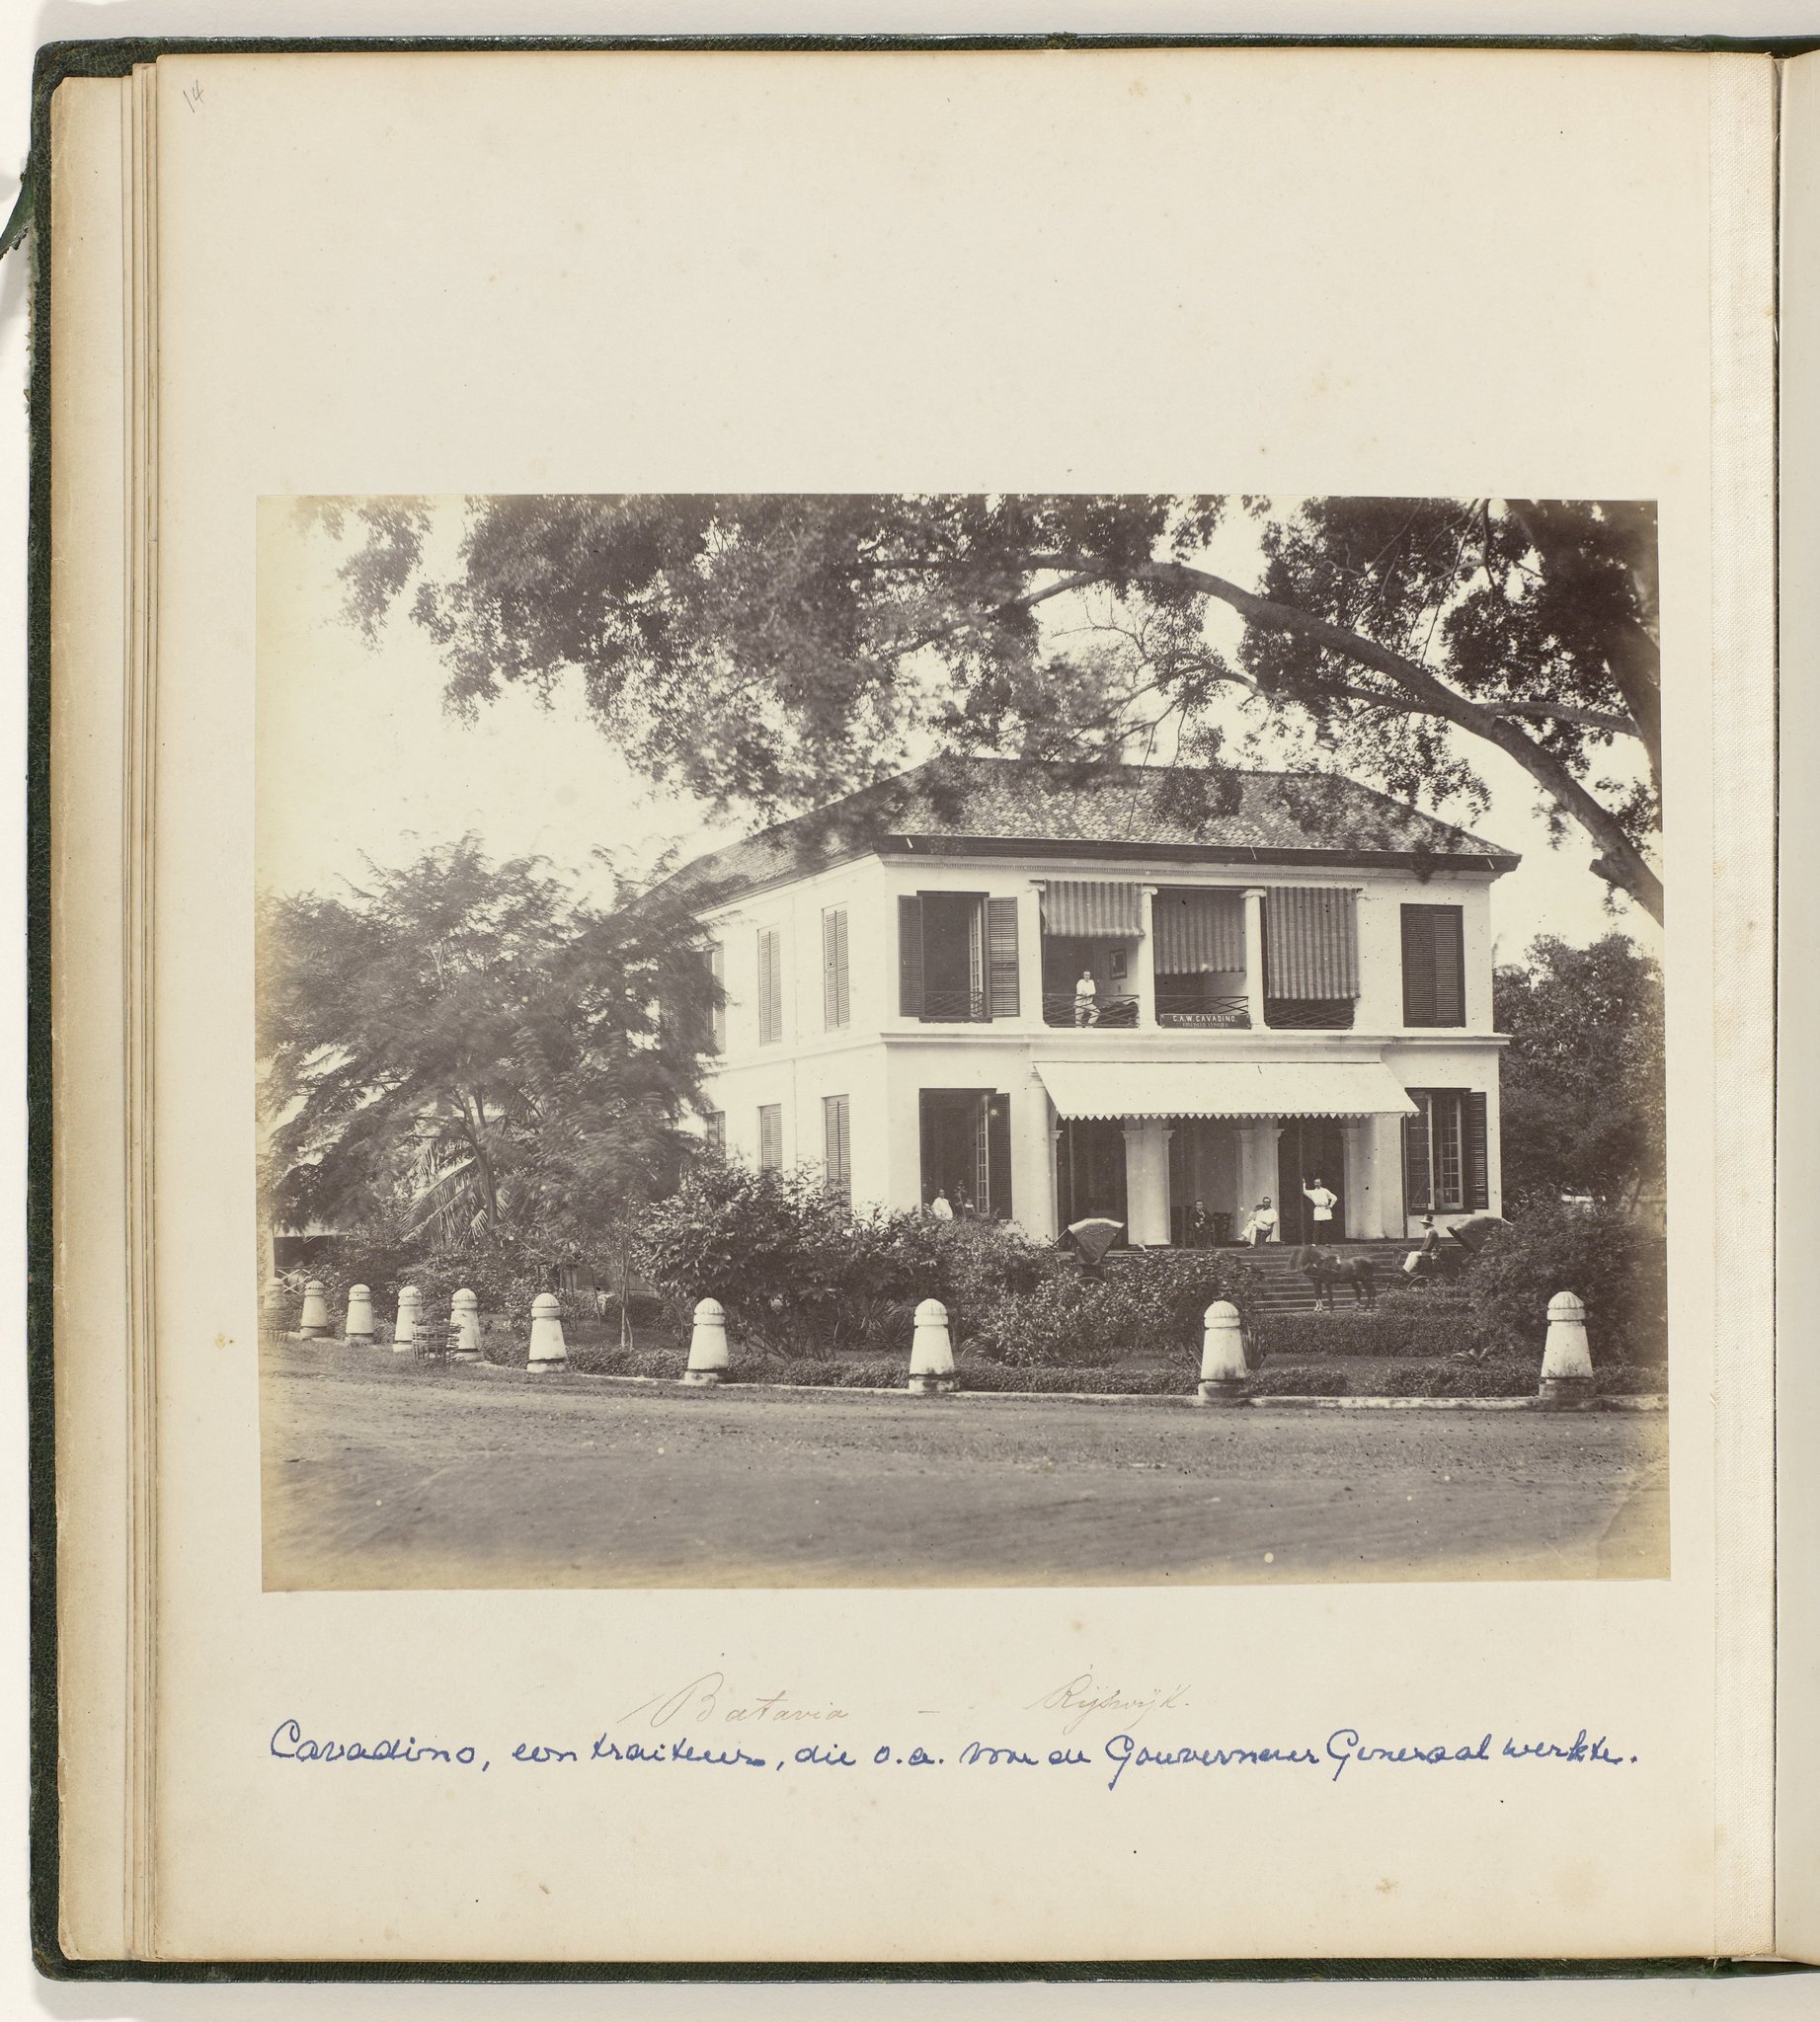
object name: photograph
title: Batavia - Rijswijk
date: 1863-1866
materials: photographic support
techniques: albumen print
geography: batavia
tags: detached house in city, batavia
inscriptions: inscription: ‘Cavadino, een traiteur, die o.a. voor de Gouverneur Generaal werkte.’, inscription: ‘Batavia - Rijswijk’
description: Woonhuis of restaurant van de traiteur C.A.W. Cavadino (later Hotel Cavadino), hoek Rijswijk en Citadelweg te Batavia. Onderdeel van het tweede groene fotoalbum met foto's van Java, uit het bezit van apotheker Specht-Grijp, die in 1865 vanuit Batavia naar Nederland terugkeerde.